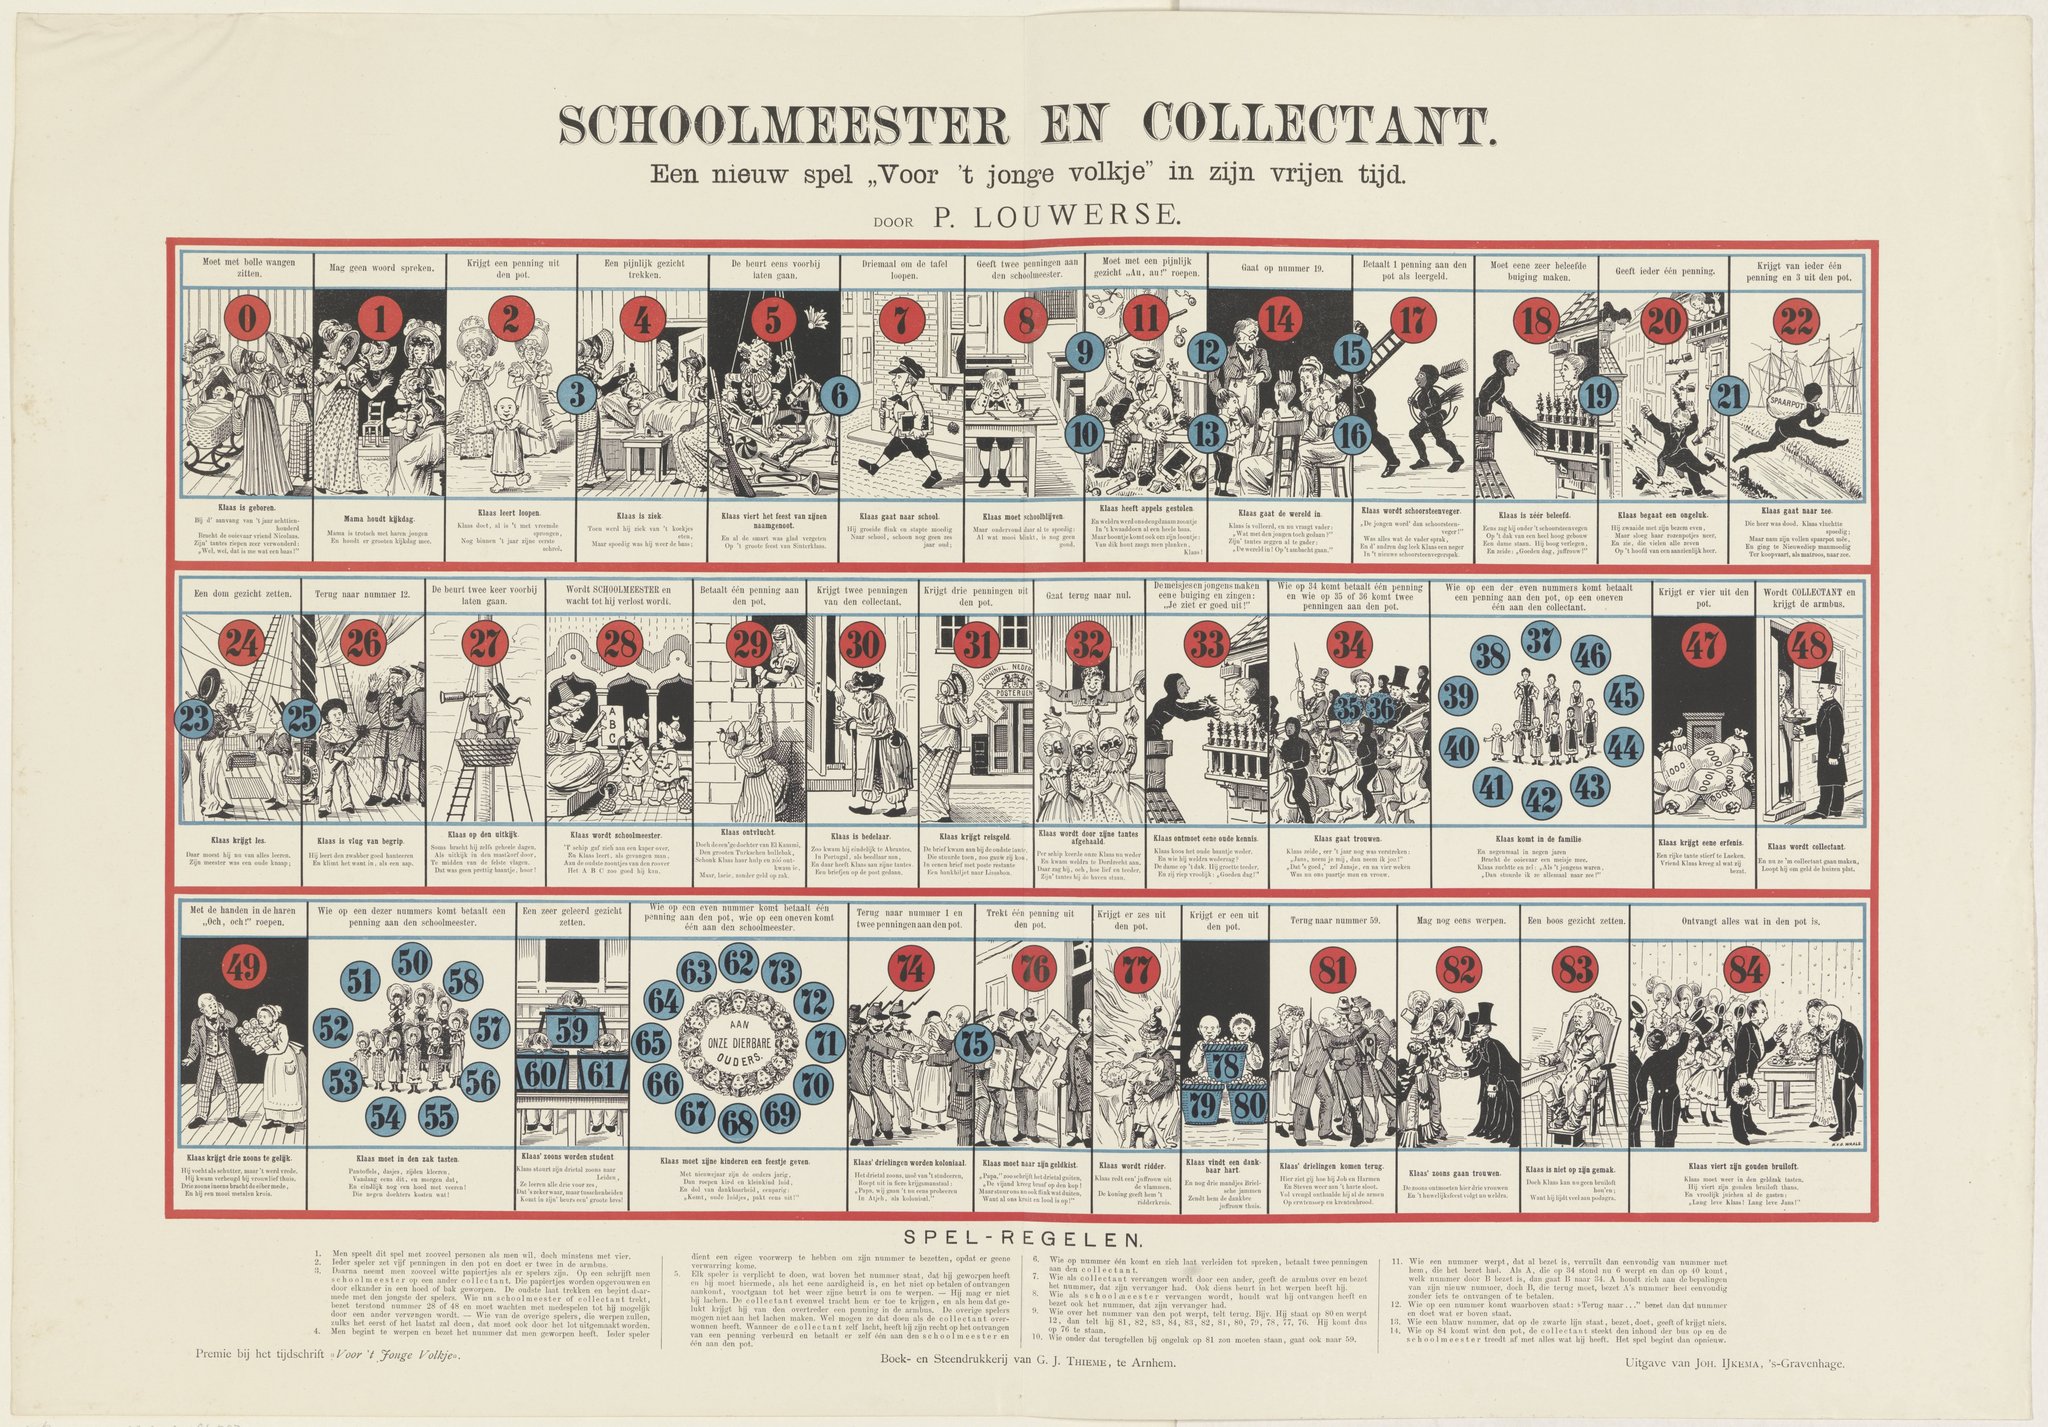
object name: popular print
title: Schoolmeester en collectant / Een nieuw spel "Voor 't jonge volkje" in zijn vrijen tijd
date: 1875-1890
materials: paper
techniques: letterpress printing, lithograph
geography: arnhem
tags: board-games of chance, teacher and pupil, board-games, human life divided into stages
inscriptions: collector's mark: Lugt 2760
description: Rechthoekig bordspel met genummerde vakjes van 0 tot en met 84, volgt gebeurtenissen uit het leven van Klaas. Na een door hem veroorzaakt dodelijk ongeluk vlucht hij naar zee. Het schip wordt gekaapt en Klaas moet als schoolmeester de zoontjes van de Turkse rover het ABC leren. Klaas weet te ontsnappen en thuis gekomen trouwt hij met Jans bij wie hij negen dochters en drie zoons krijgt. Na een flinke erfenis kan Klaas het kalm aandoen en maakt hij zich als collectant door het inzamelen van giften nuttig. Bij nummer 84 viert hij zijn gouden bruiloft. In de ondermarge de spelregels in vier kolommen, midden boven de titel van het spel.